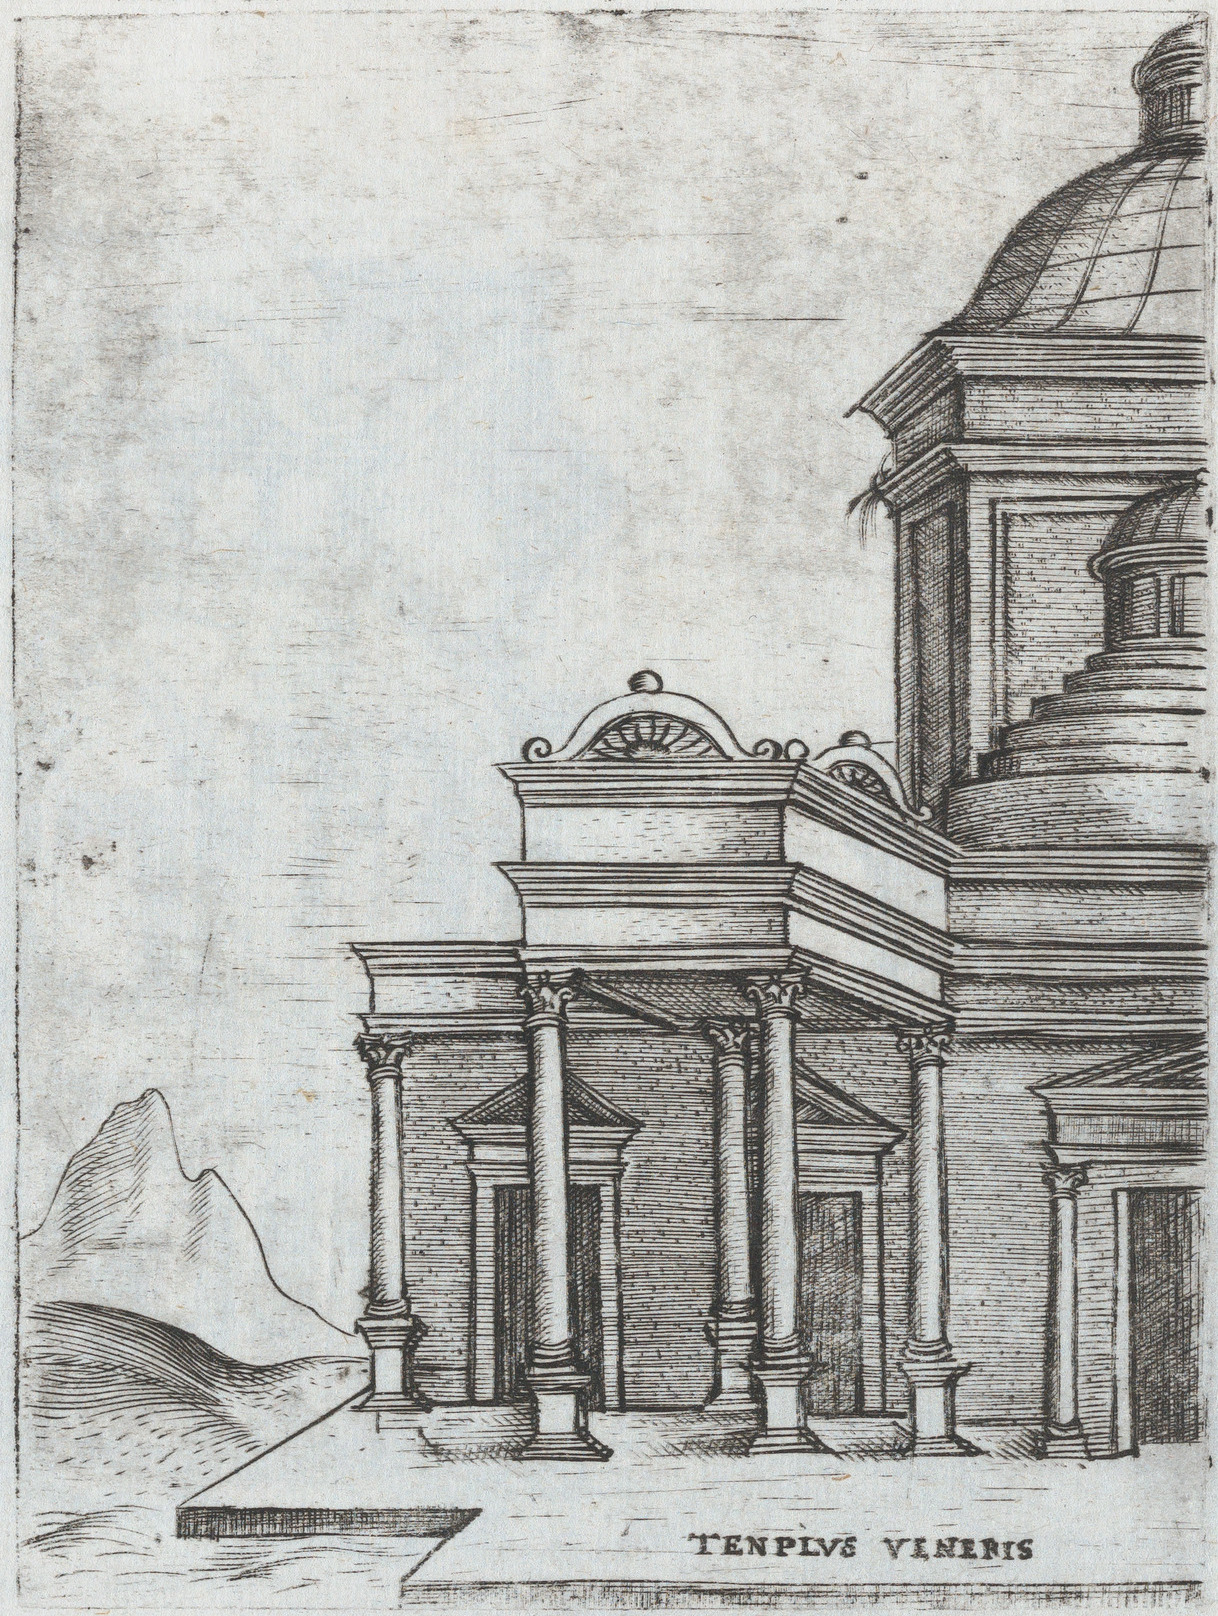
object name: album print ornament architecture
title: Arcus Lutii Septimii, from a Series of Prints depicting (reconstructed) Buildings from Roman Antiquity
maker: monogrammist g.a. with the caltrop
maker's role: artist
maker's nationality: italian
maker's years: 1535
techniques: engraving, printing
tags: architecture